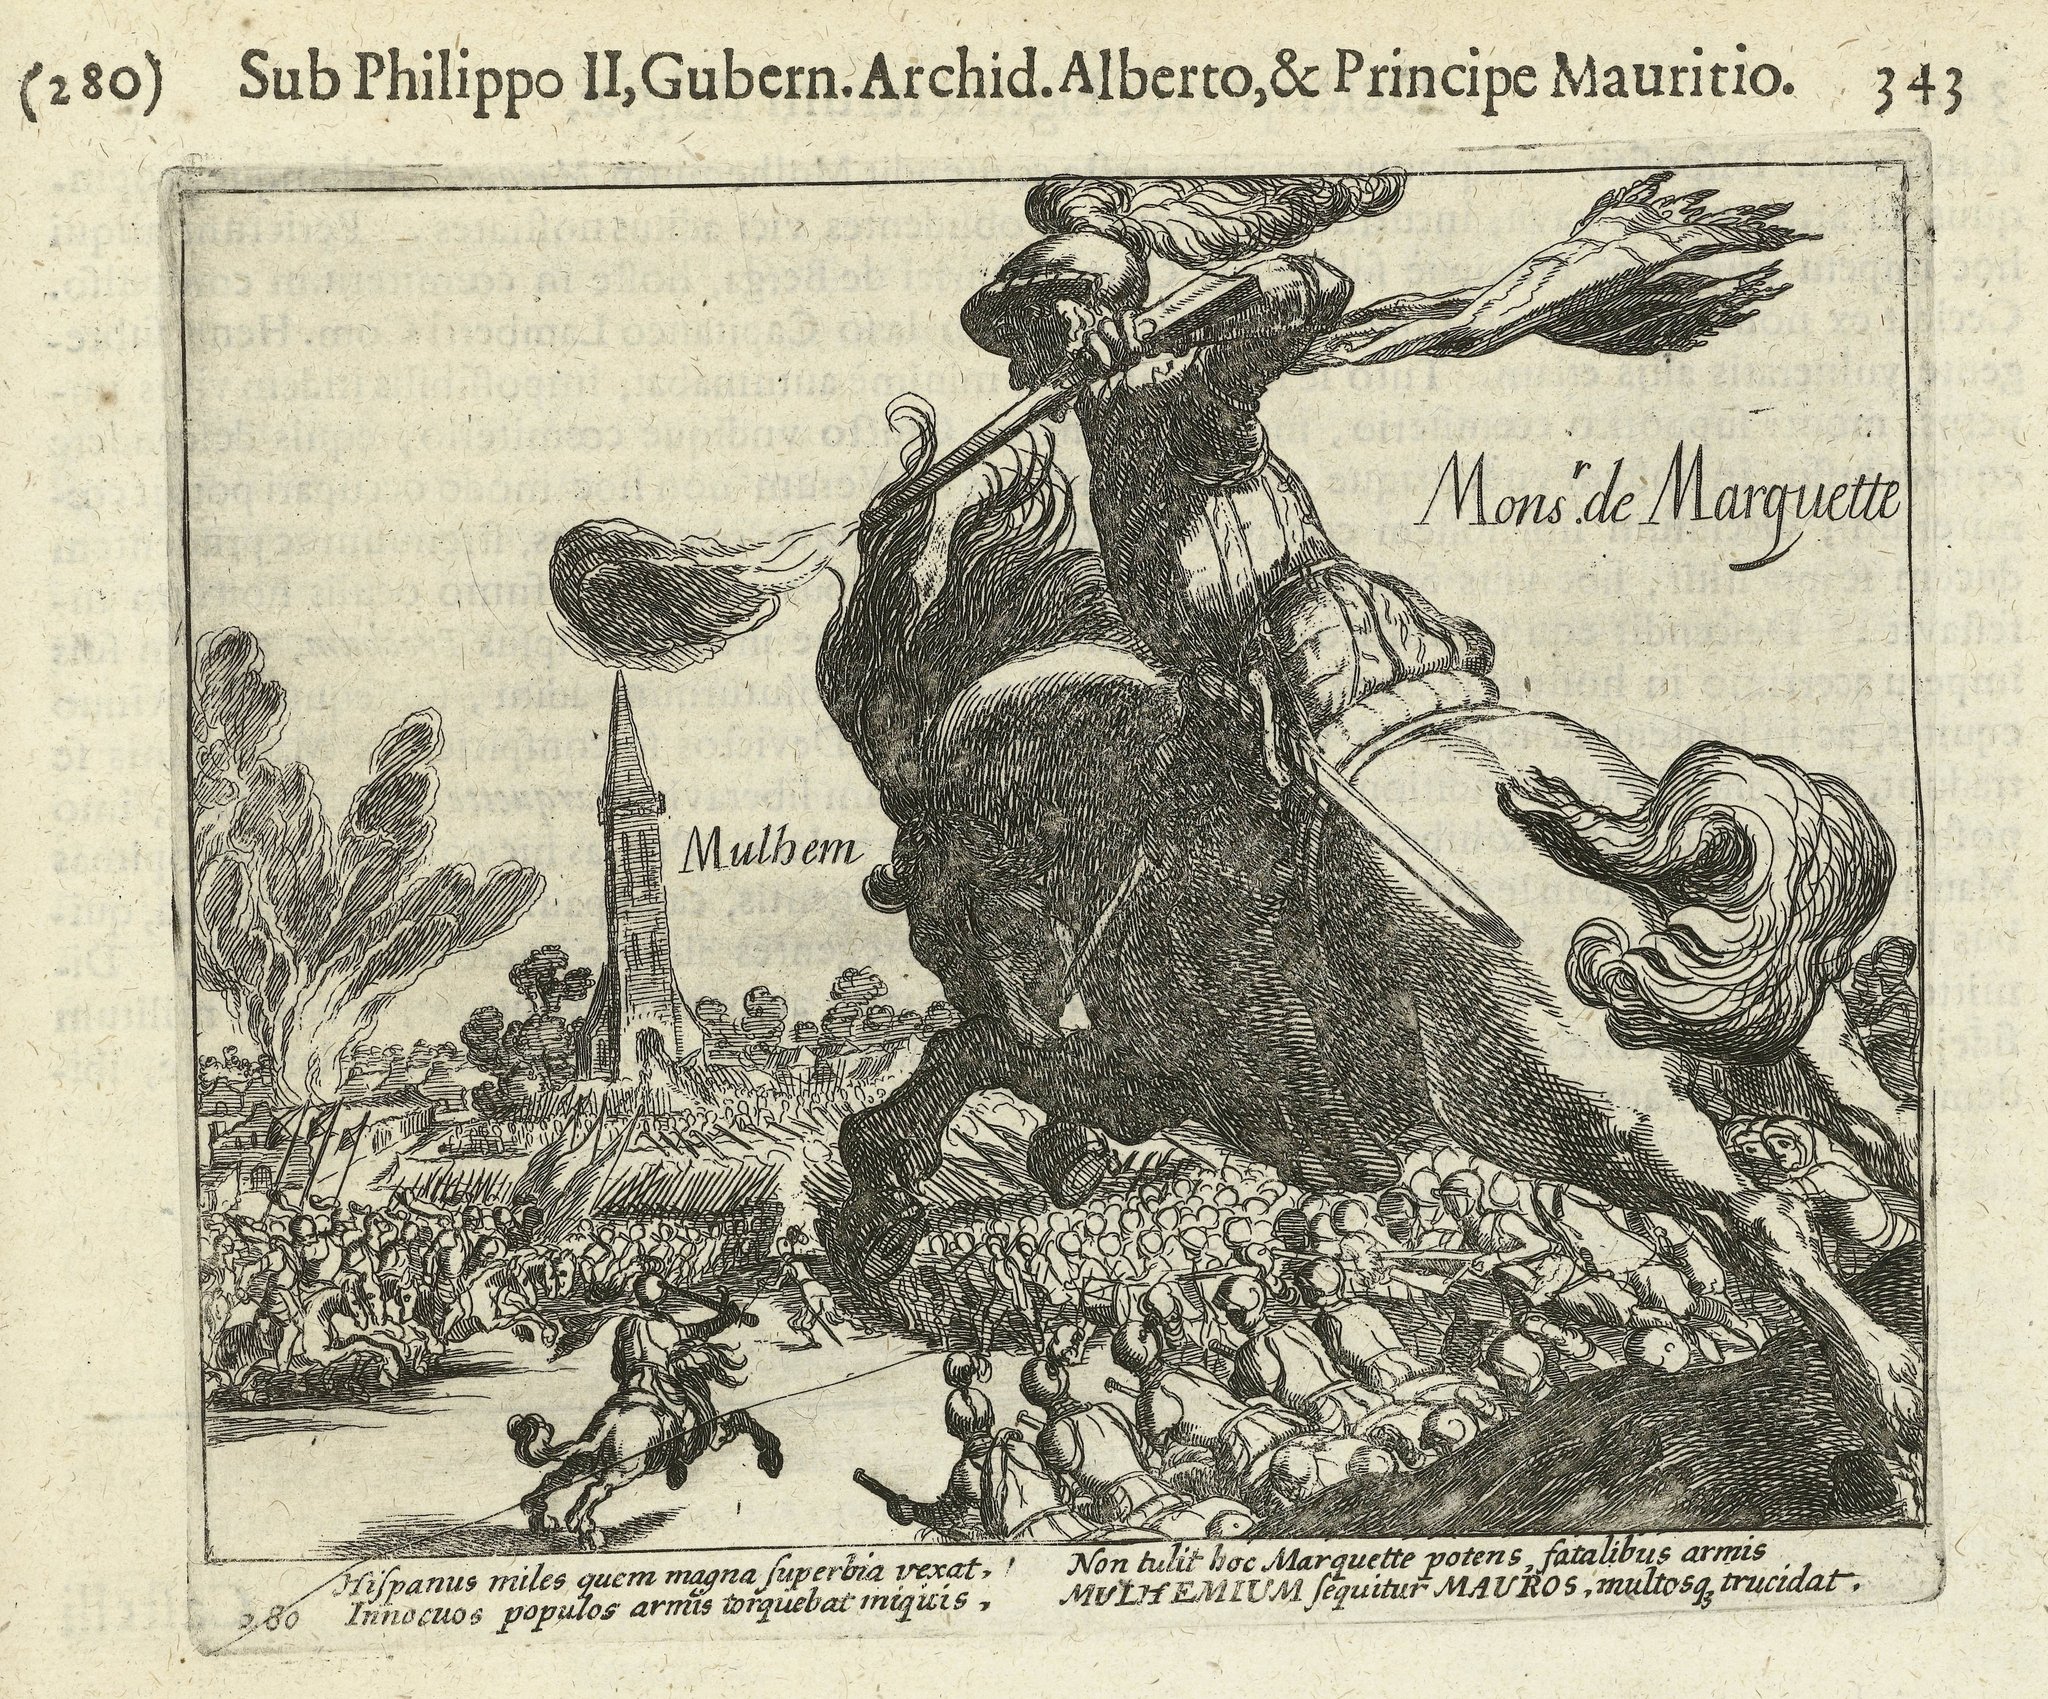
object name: print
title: Spanjaarden verslagen door het Staatse leger onder Marquette bij Mülheim, 1608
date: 1613-1615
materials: paper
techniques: etching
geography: northern netherlands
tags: battle (+ land forces)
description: Spanjaarden verslagen door het Staatse leger onder Marquette bij Mülheim, 1608. Op de voorgrond een ruiter die zijn musket vuurt. Met onderschrift van 4 regels in het Latijn. Genummerd: 280. Bedrukt op achterzijde met tekst in het Latijn.